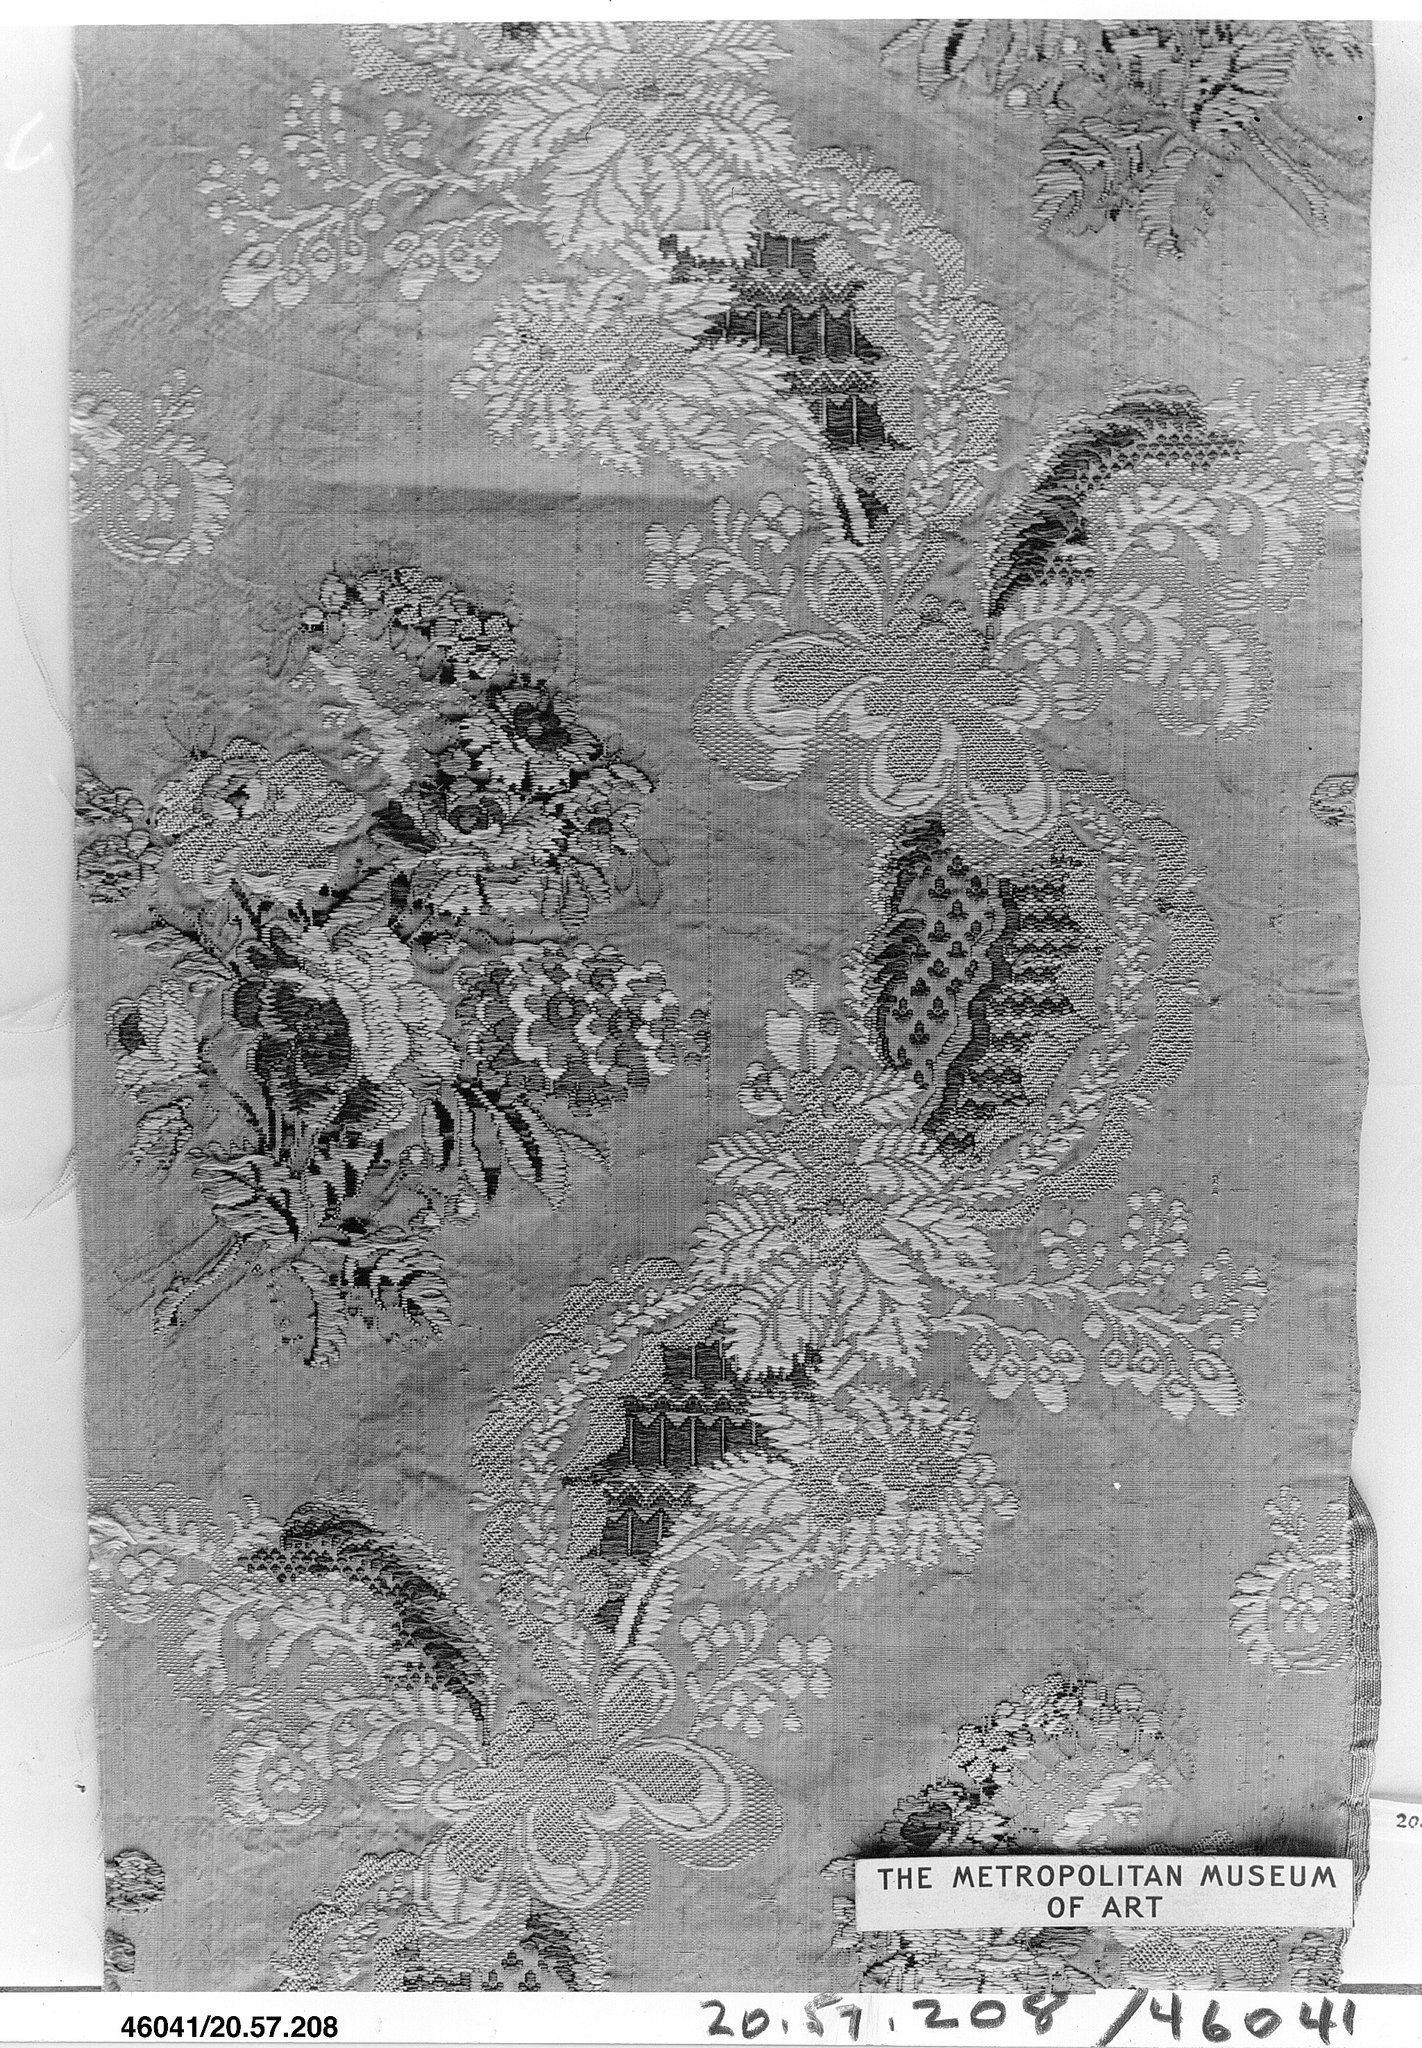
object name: piece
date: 1750-1760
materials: silk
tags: flowers,leaves